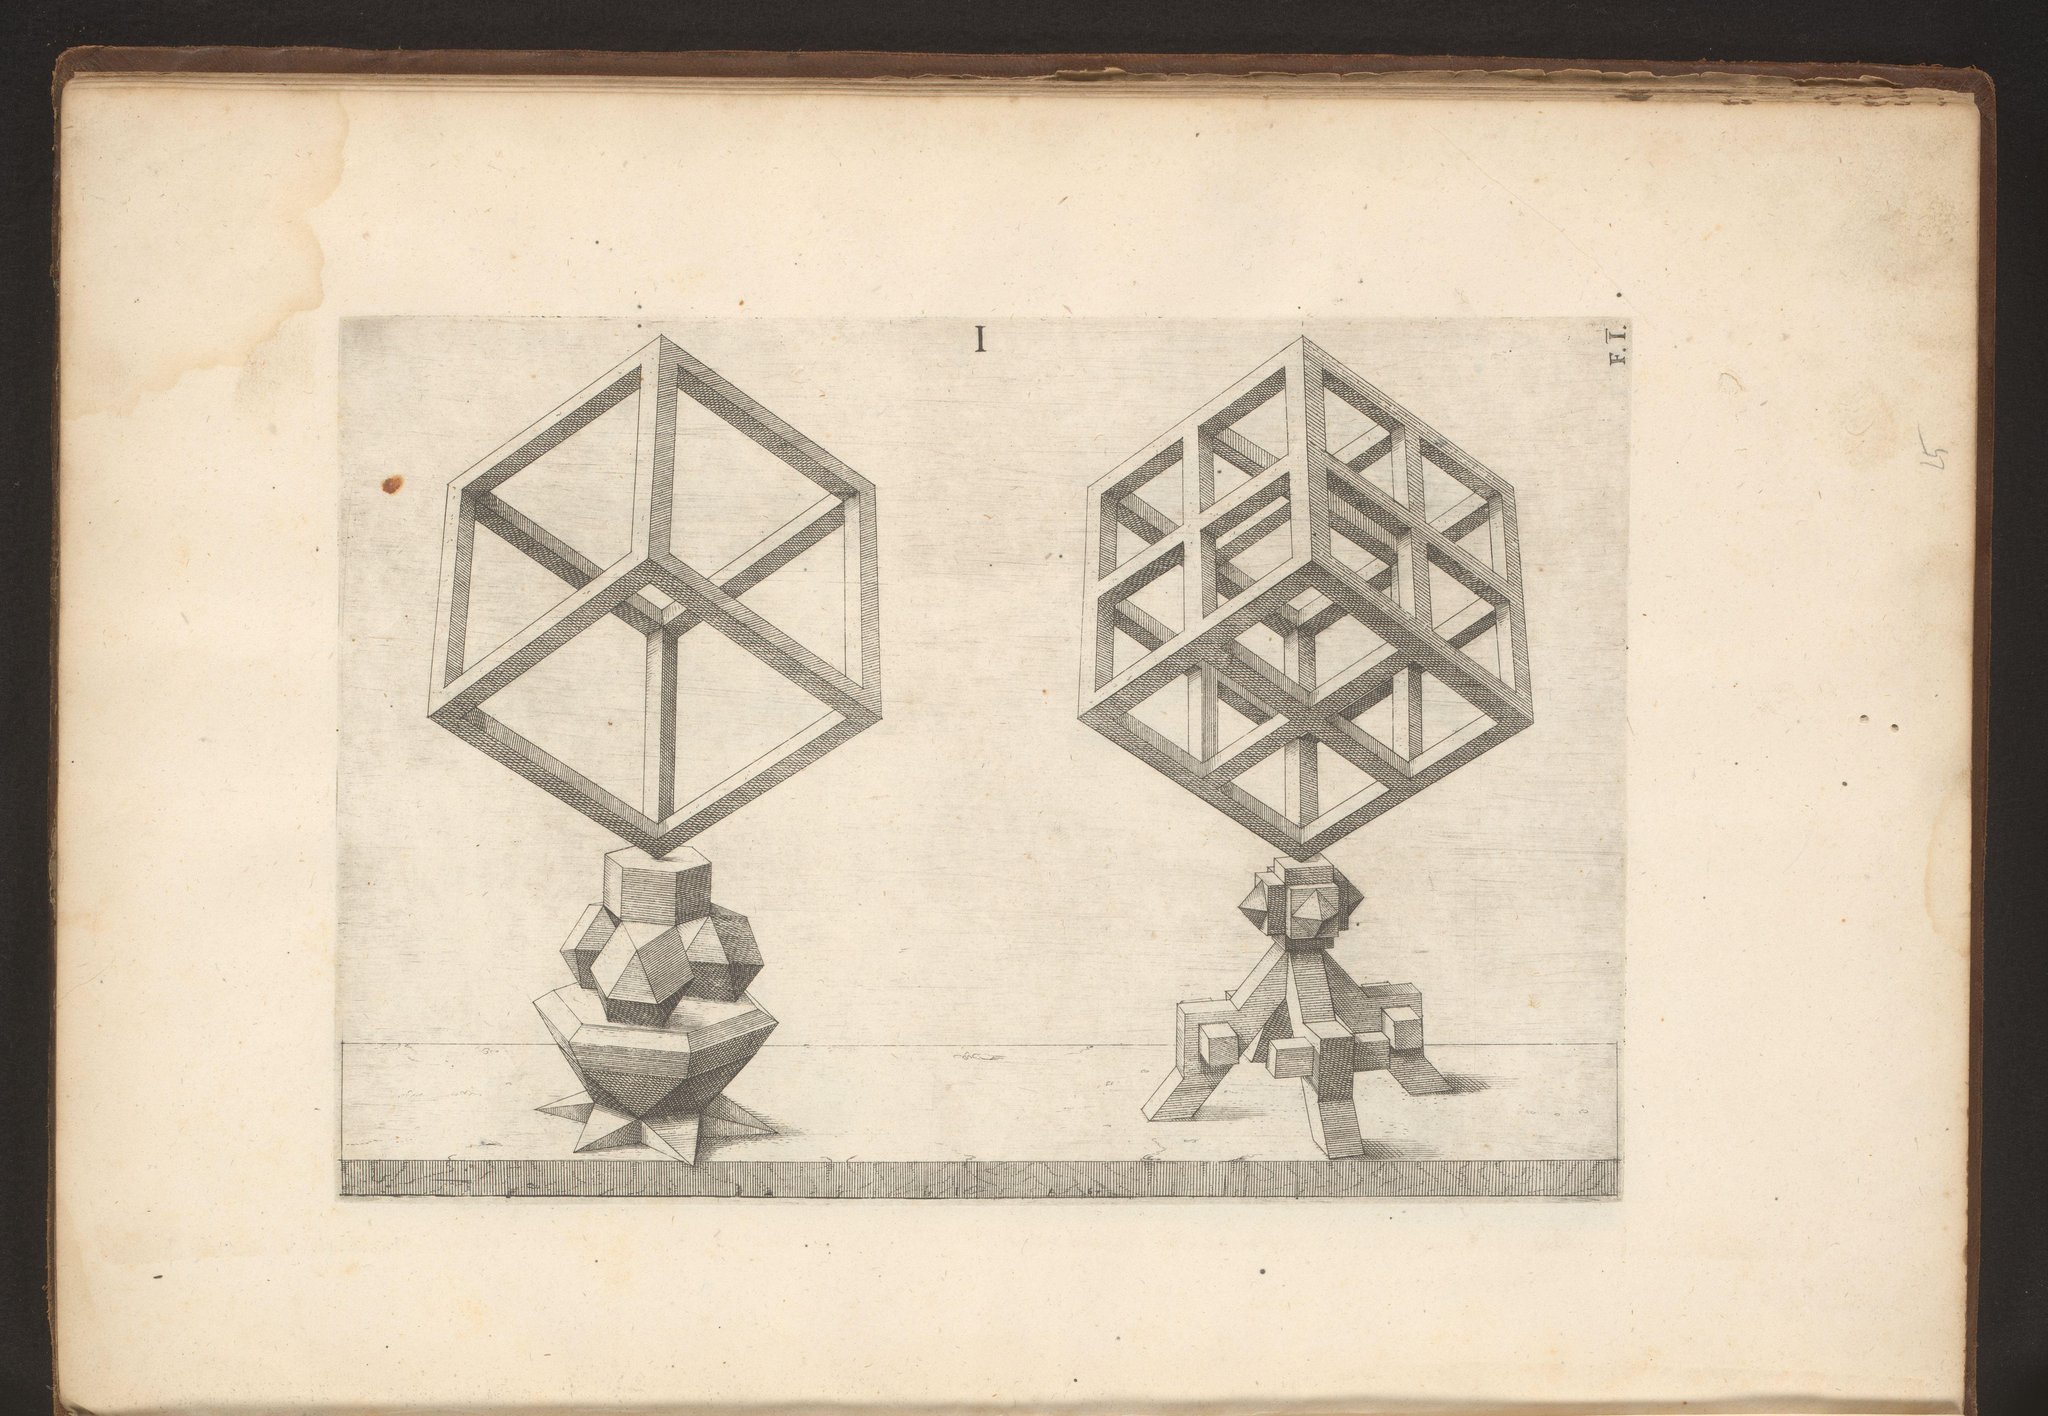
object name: print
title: Twee veelvlakken met een hexaëder als uitgangspunt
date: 1568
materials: paper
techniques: etching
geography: nuremberg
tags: hexahedron, cube, other polyhedrons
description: De geometrische figuren (polyhedra) worden van links naar rechts complexer. Gelabeld als 'I' en genummerd: F.I. Deze prent maakt deel uit van een boek.